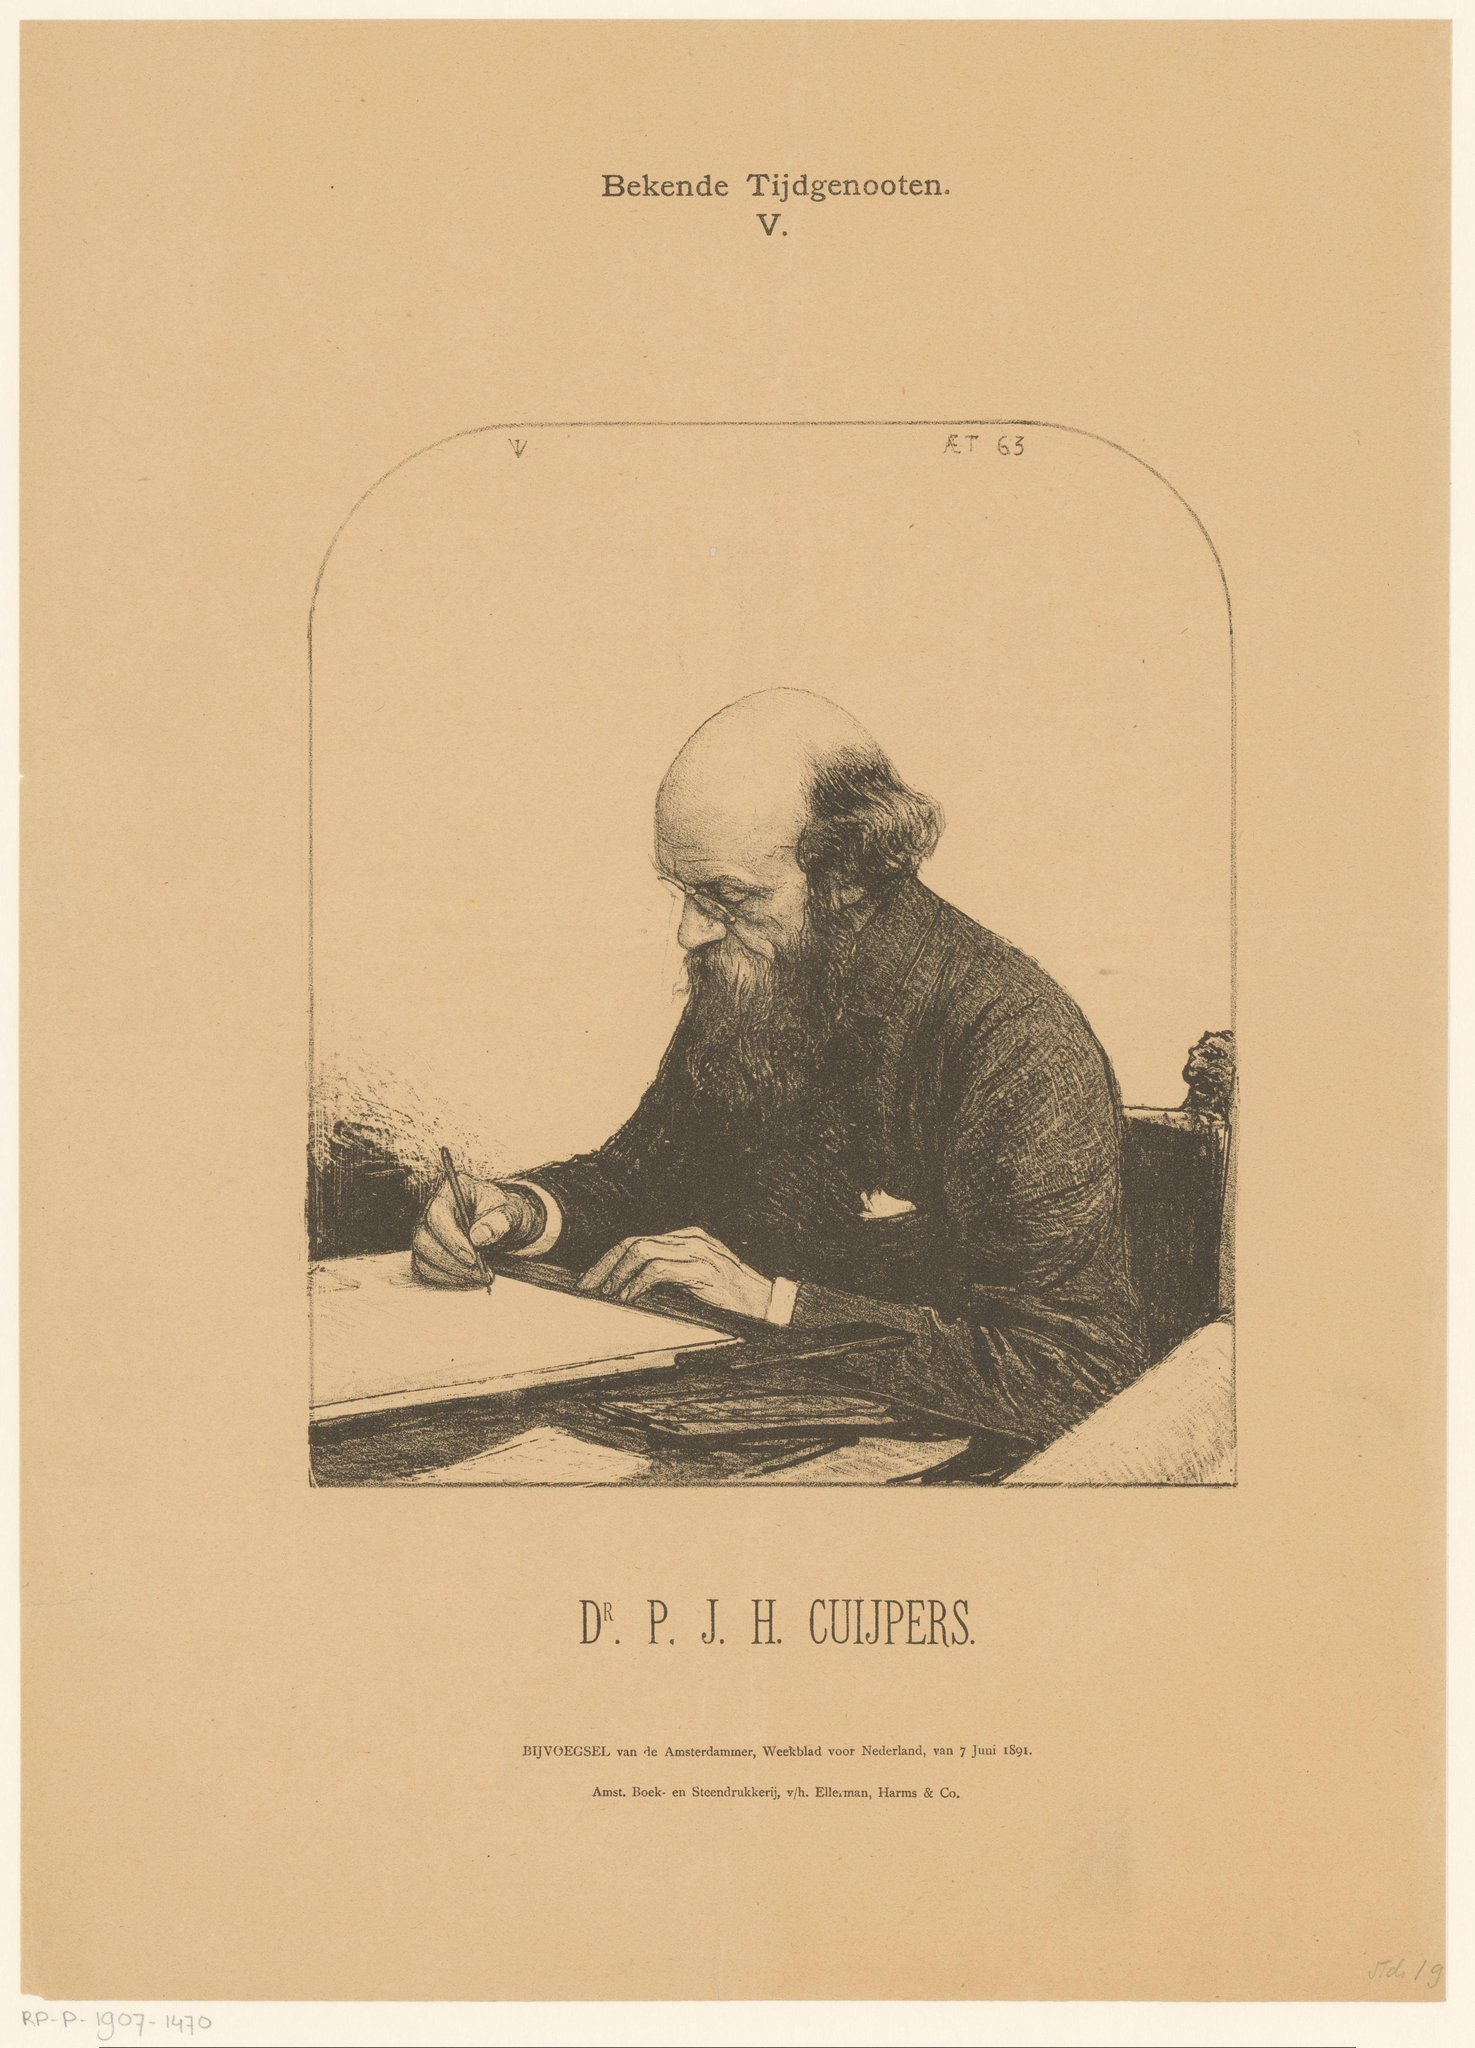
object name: print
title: Portret van Pierre Joseph Hubert Cuypers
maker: jan veth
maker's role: designer, draughtsman, painter, print maker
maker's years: 1864-1925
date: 1891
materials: paper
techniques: lithograph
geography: amsterdam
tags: draughtsman, pierre joseph hubert cuypers, historical persons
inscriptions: collector's mark: Lugt 2228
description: Deze prent werd uitgegeven als bijvoegsel van De Amsterdammer op 7 juni 1891.